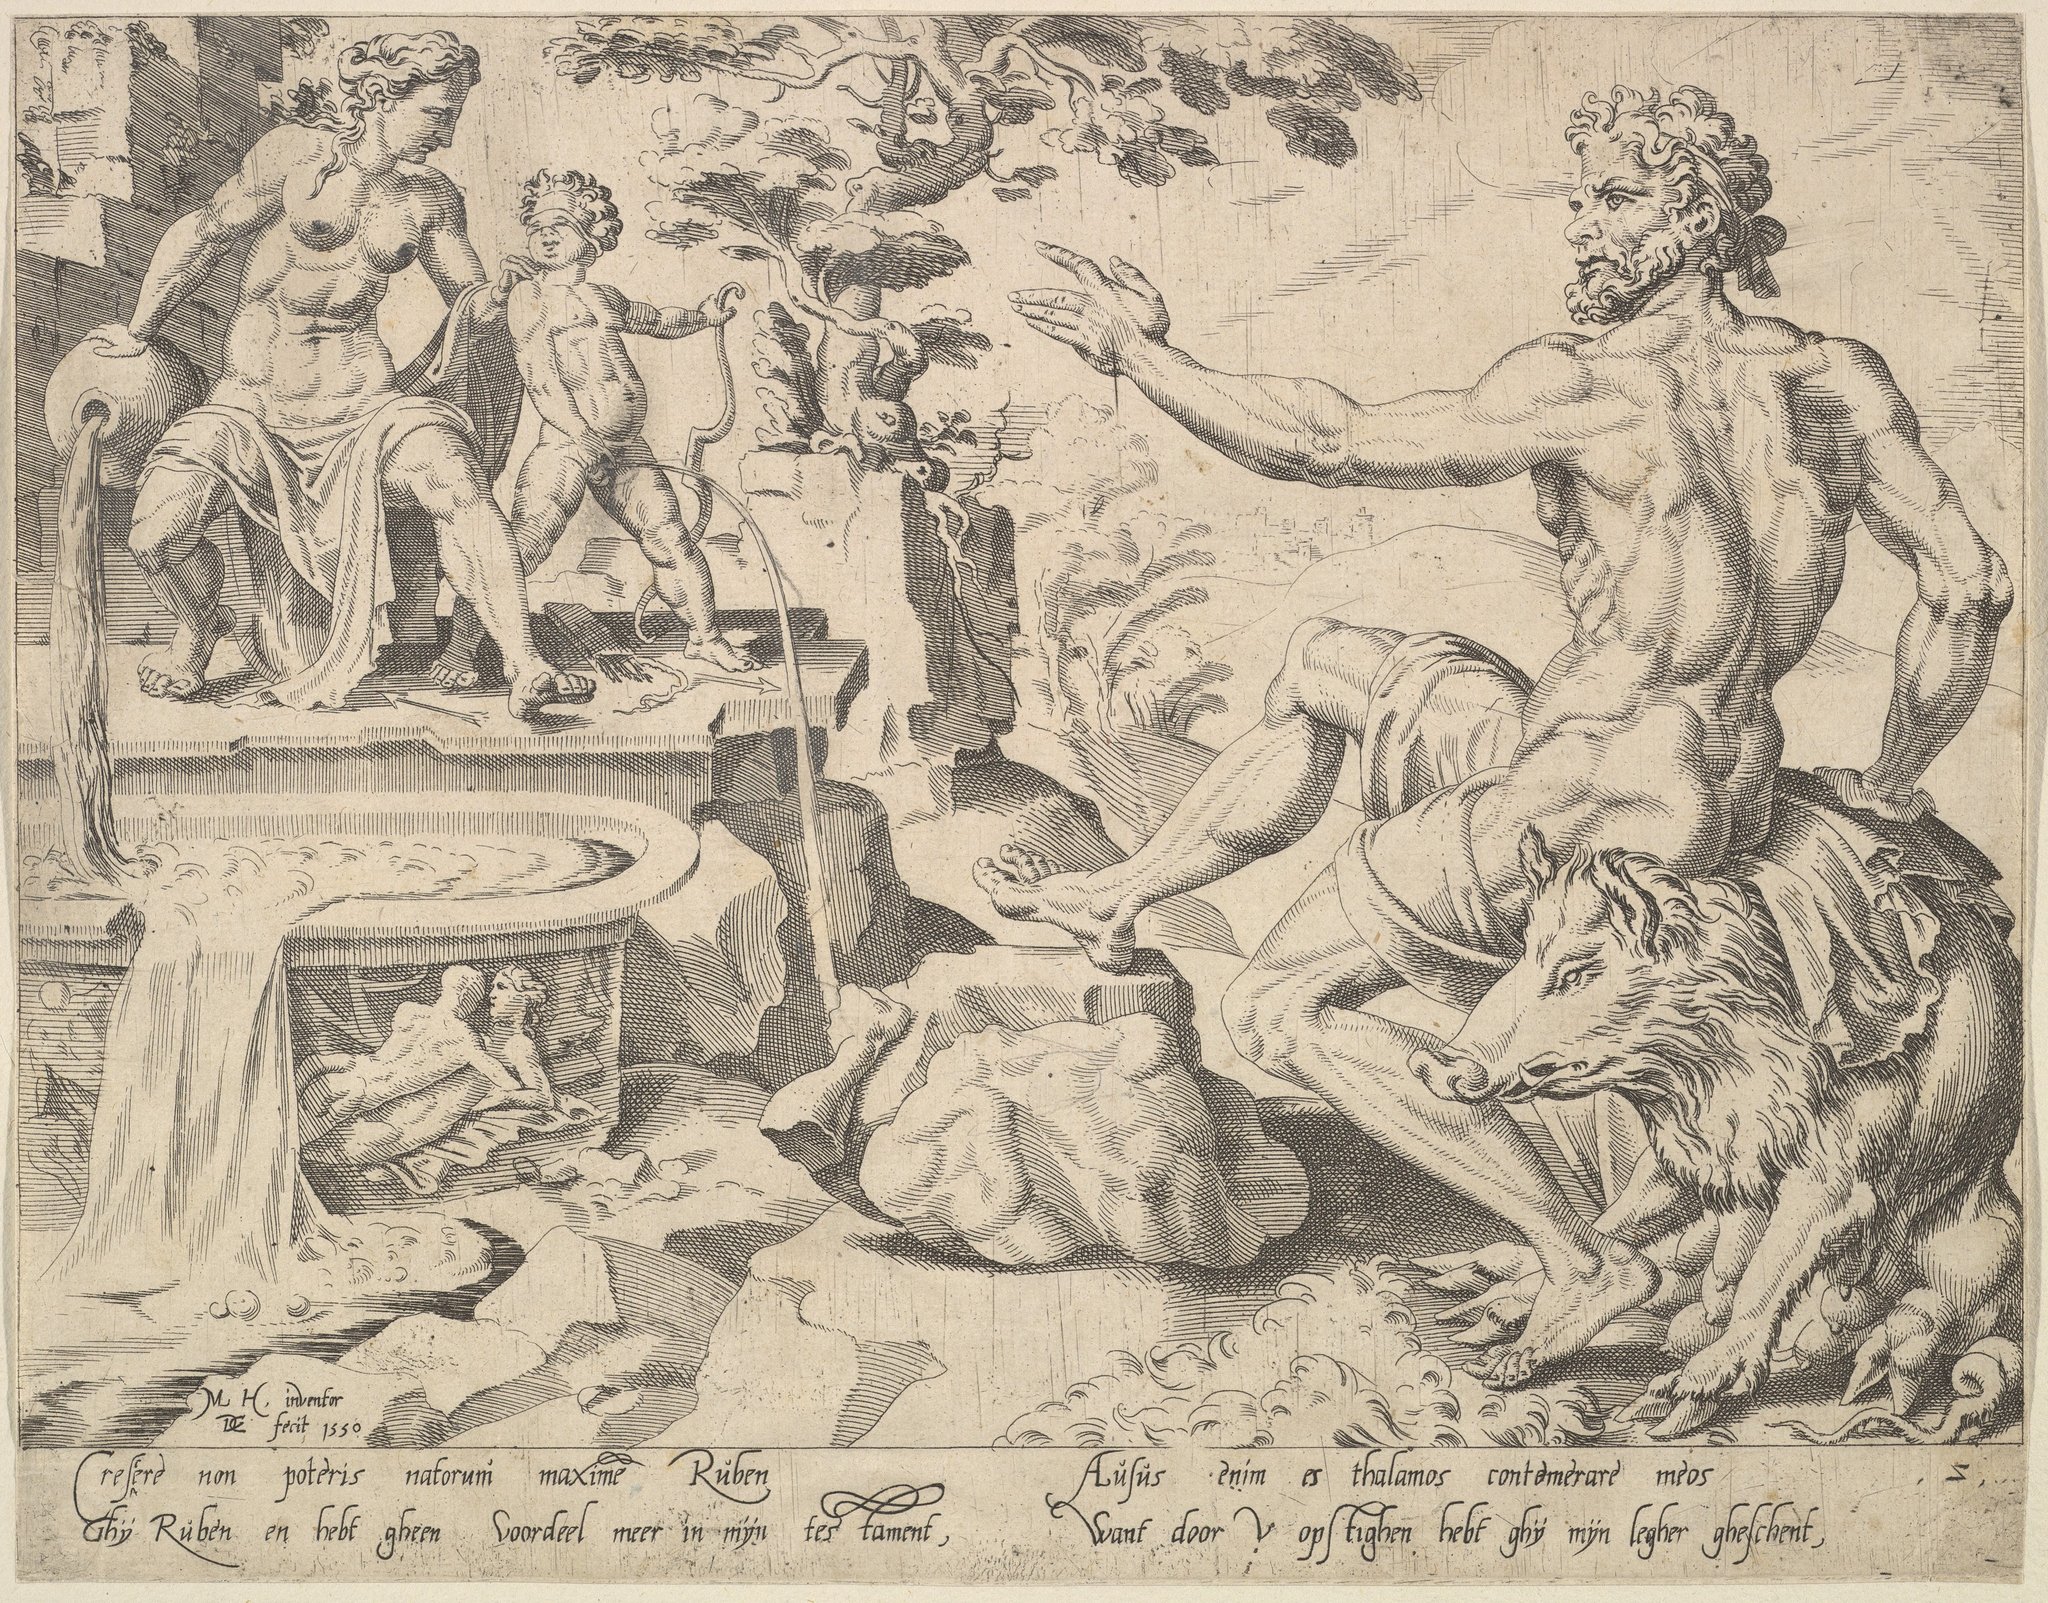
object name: print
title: Reuben [Genesis 49:3-4], from "The Twelve Patriarchs"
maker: maarten van heemskerck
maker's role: artist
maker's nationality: netherlandish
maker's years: 1498-1574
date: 1550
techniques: etching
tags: male nudes,cupid,boars